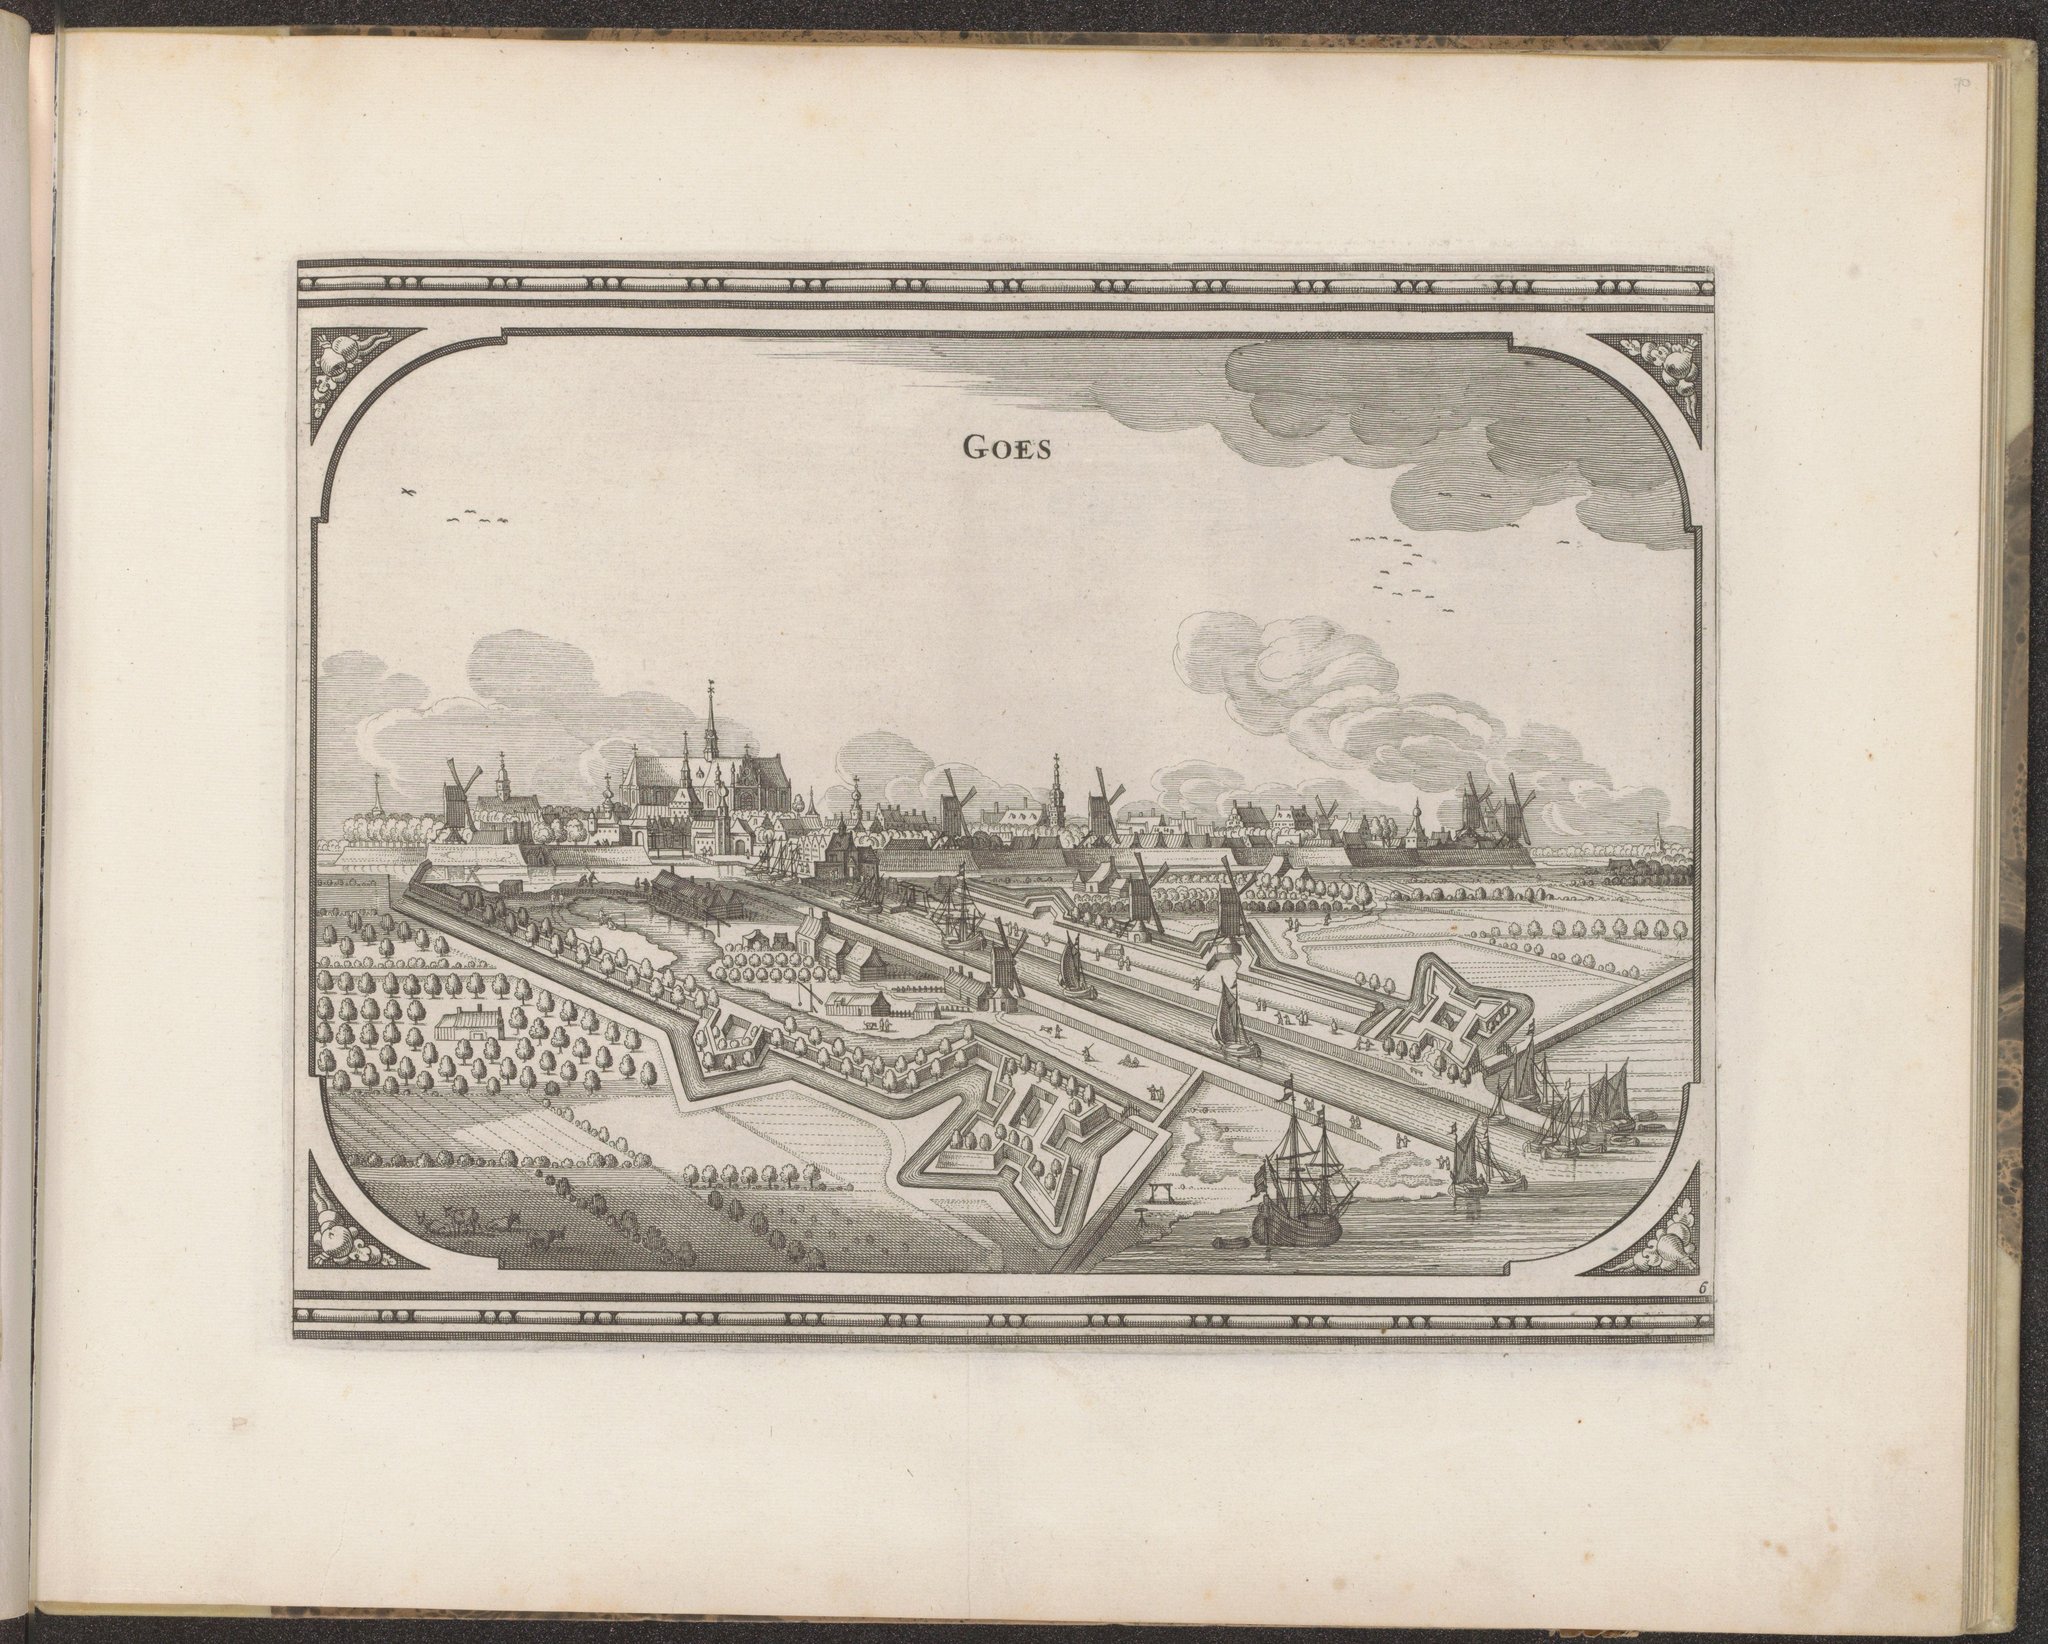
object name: album leaf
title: Speculum Zelandiae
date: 1662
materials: paper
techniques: etching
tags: city-view, and landscape with man-made constructions, canal, factories and mills in landscape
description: Gezicht op de stad Goes. Op het kanaal naar de stad varen verschillende boten en schepen. De prent maakt deel uit van een album.